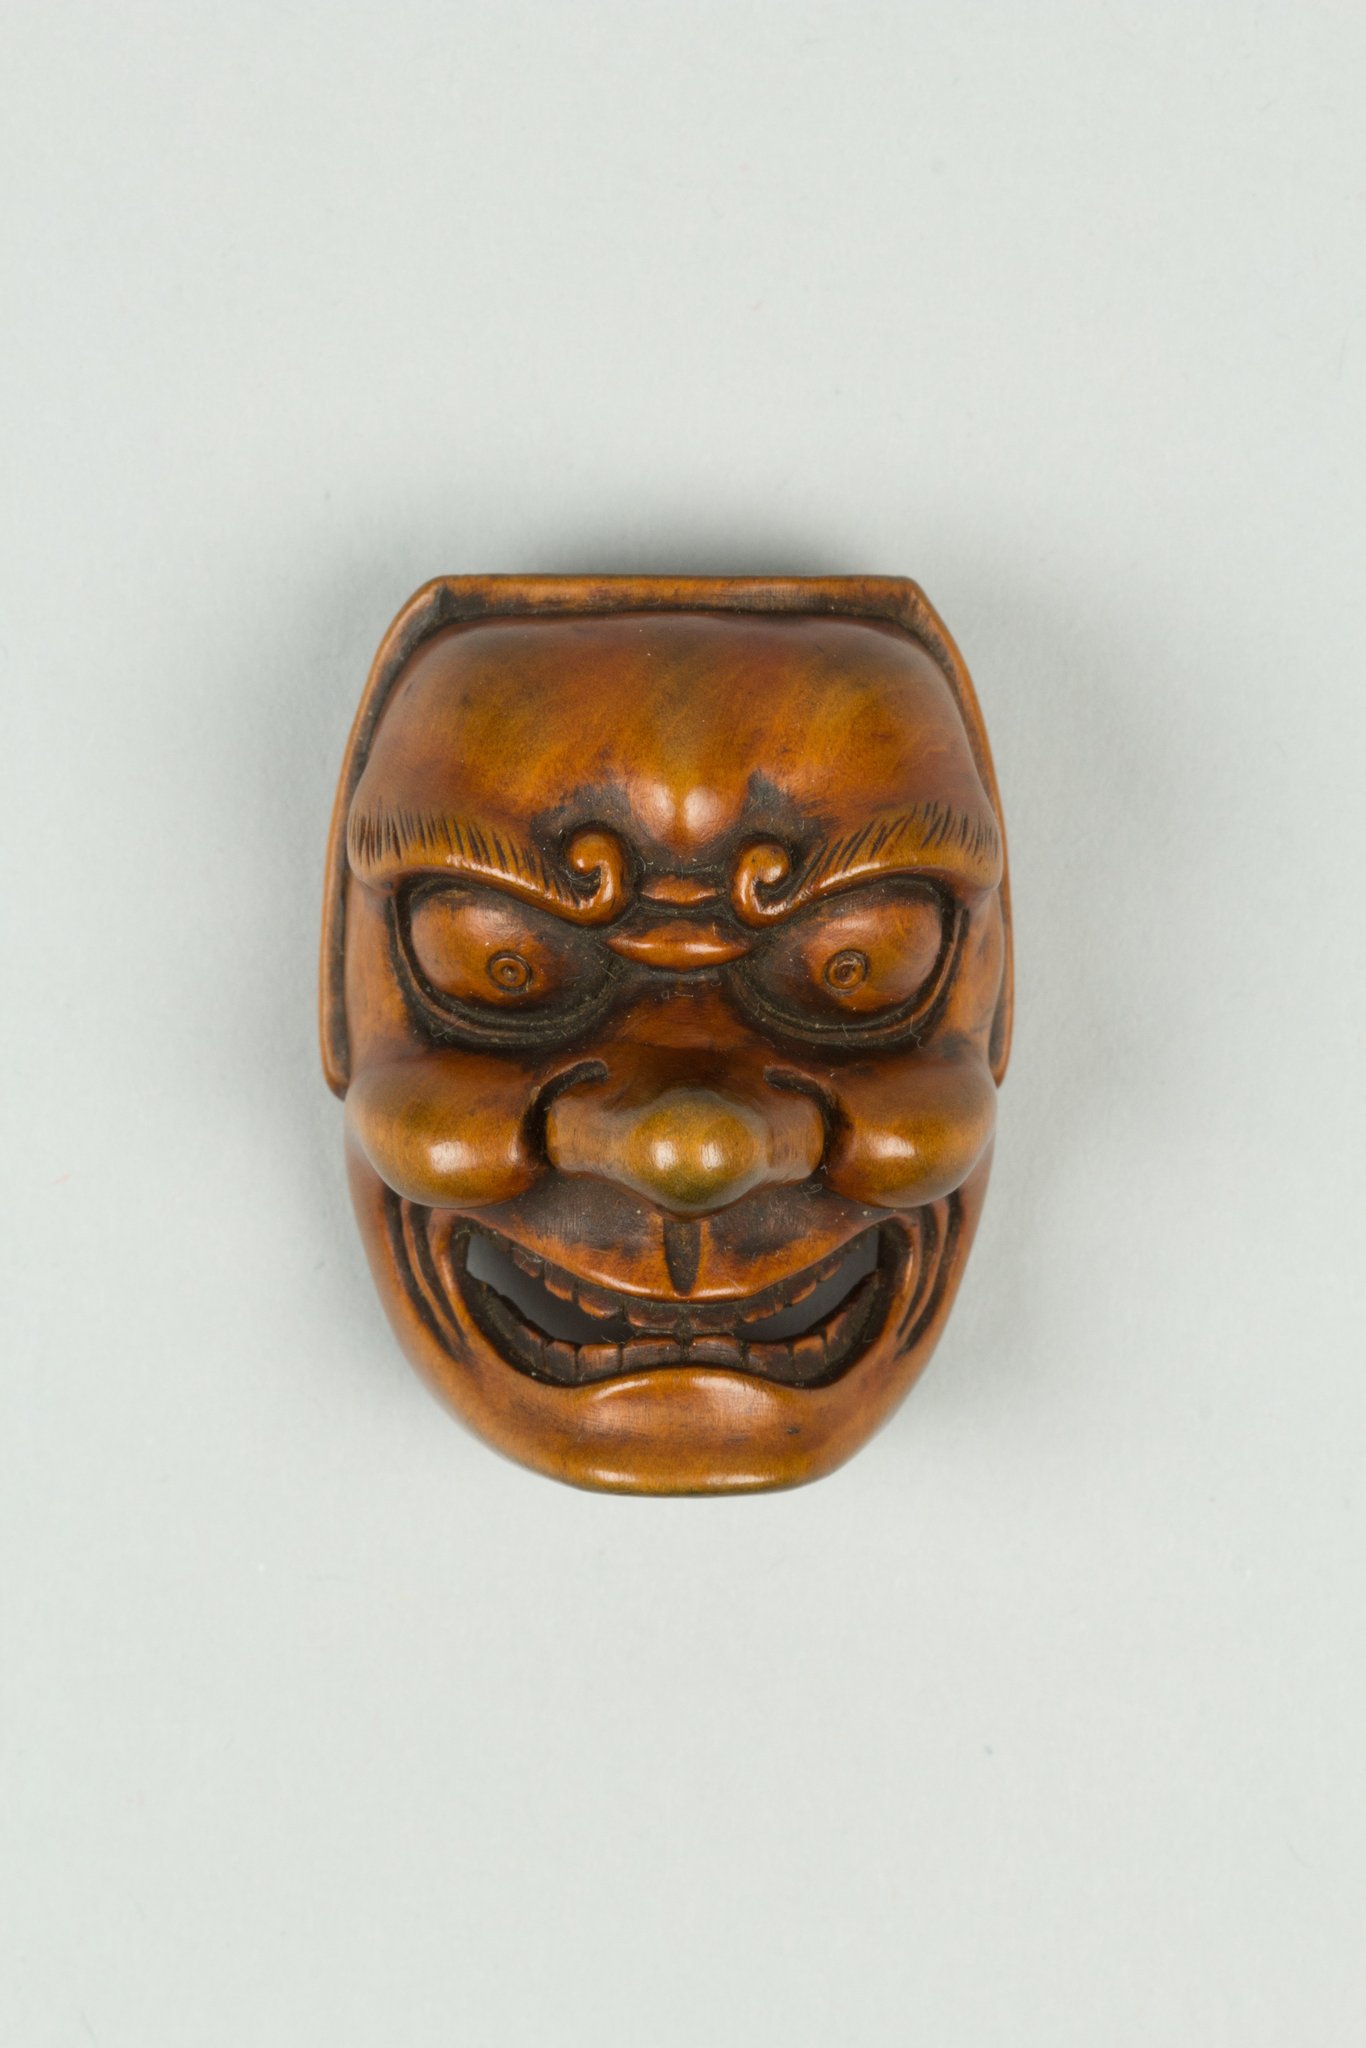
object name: netsuke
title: Netsuke of Demon Mask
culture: japanese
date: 1801-1900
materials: wood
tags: masks,demons